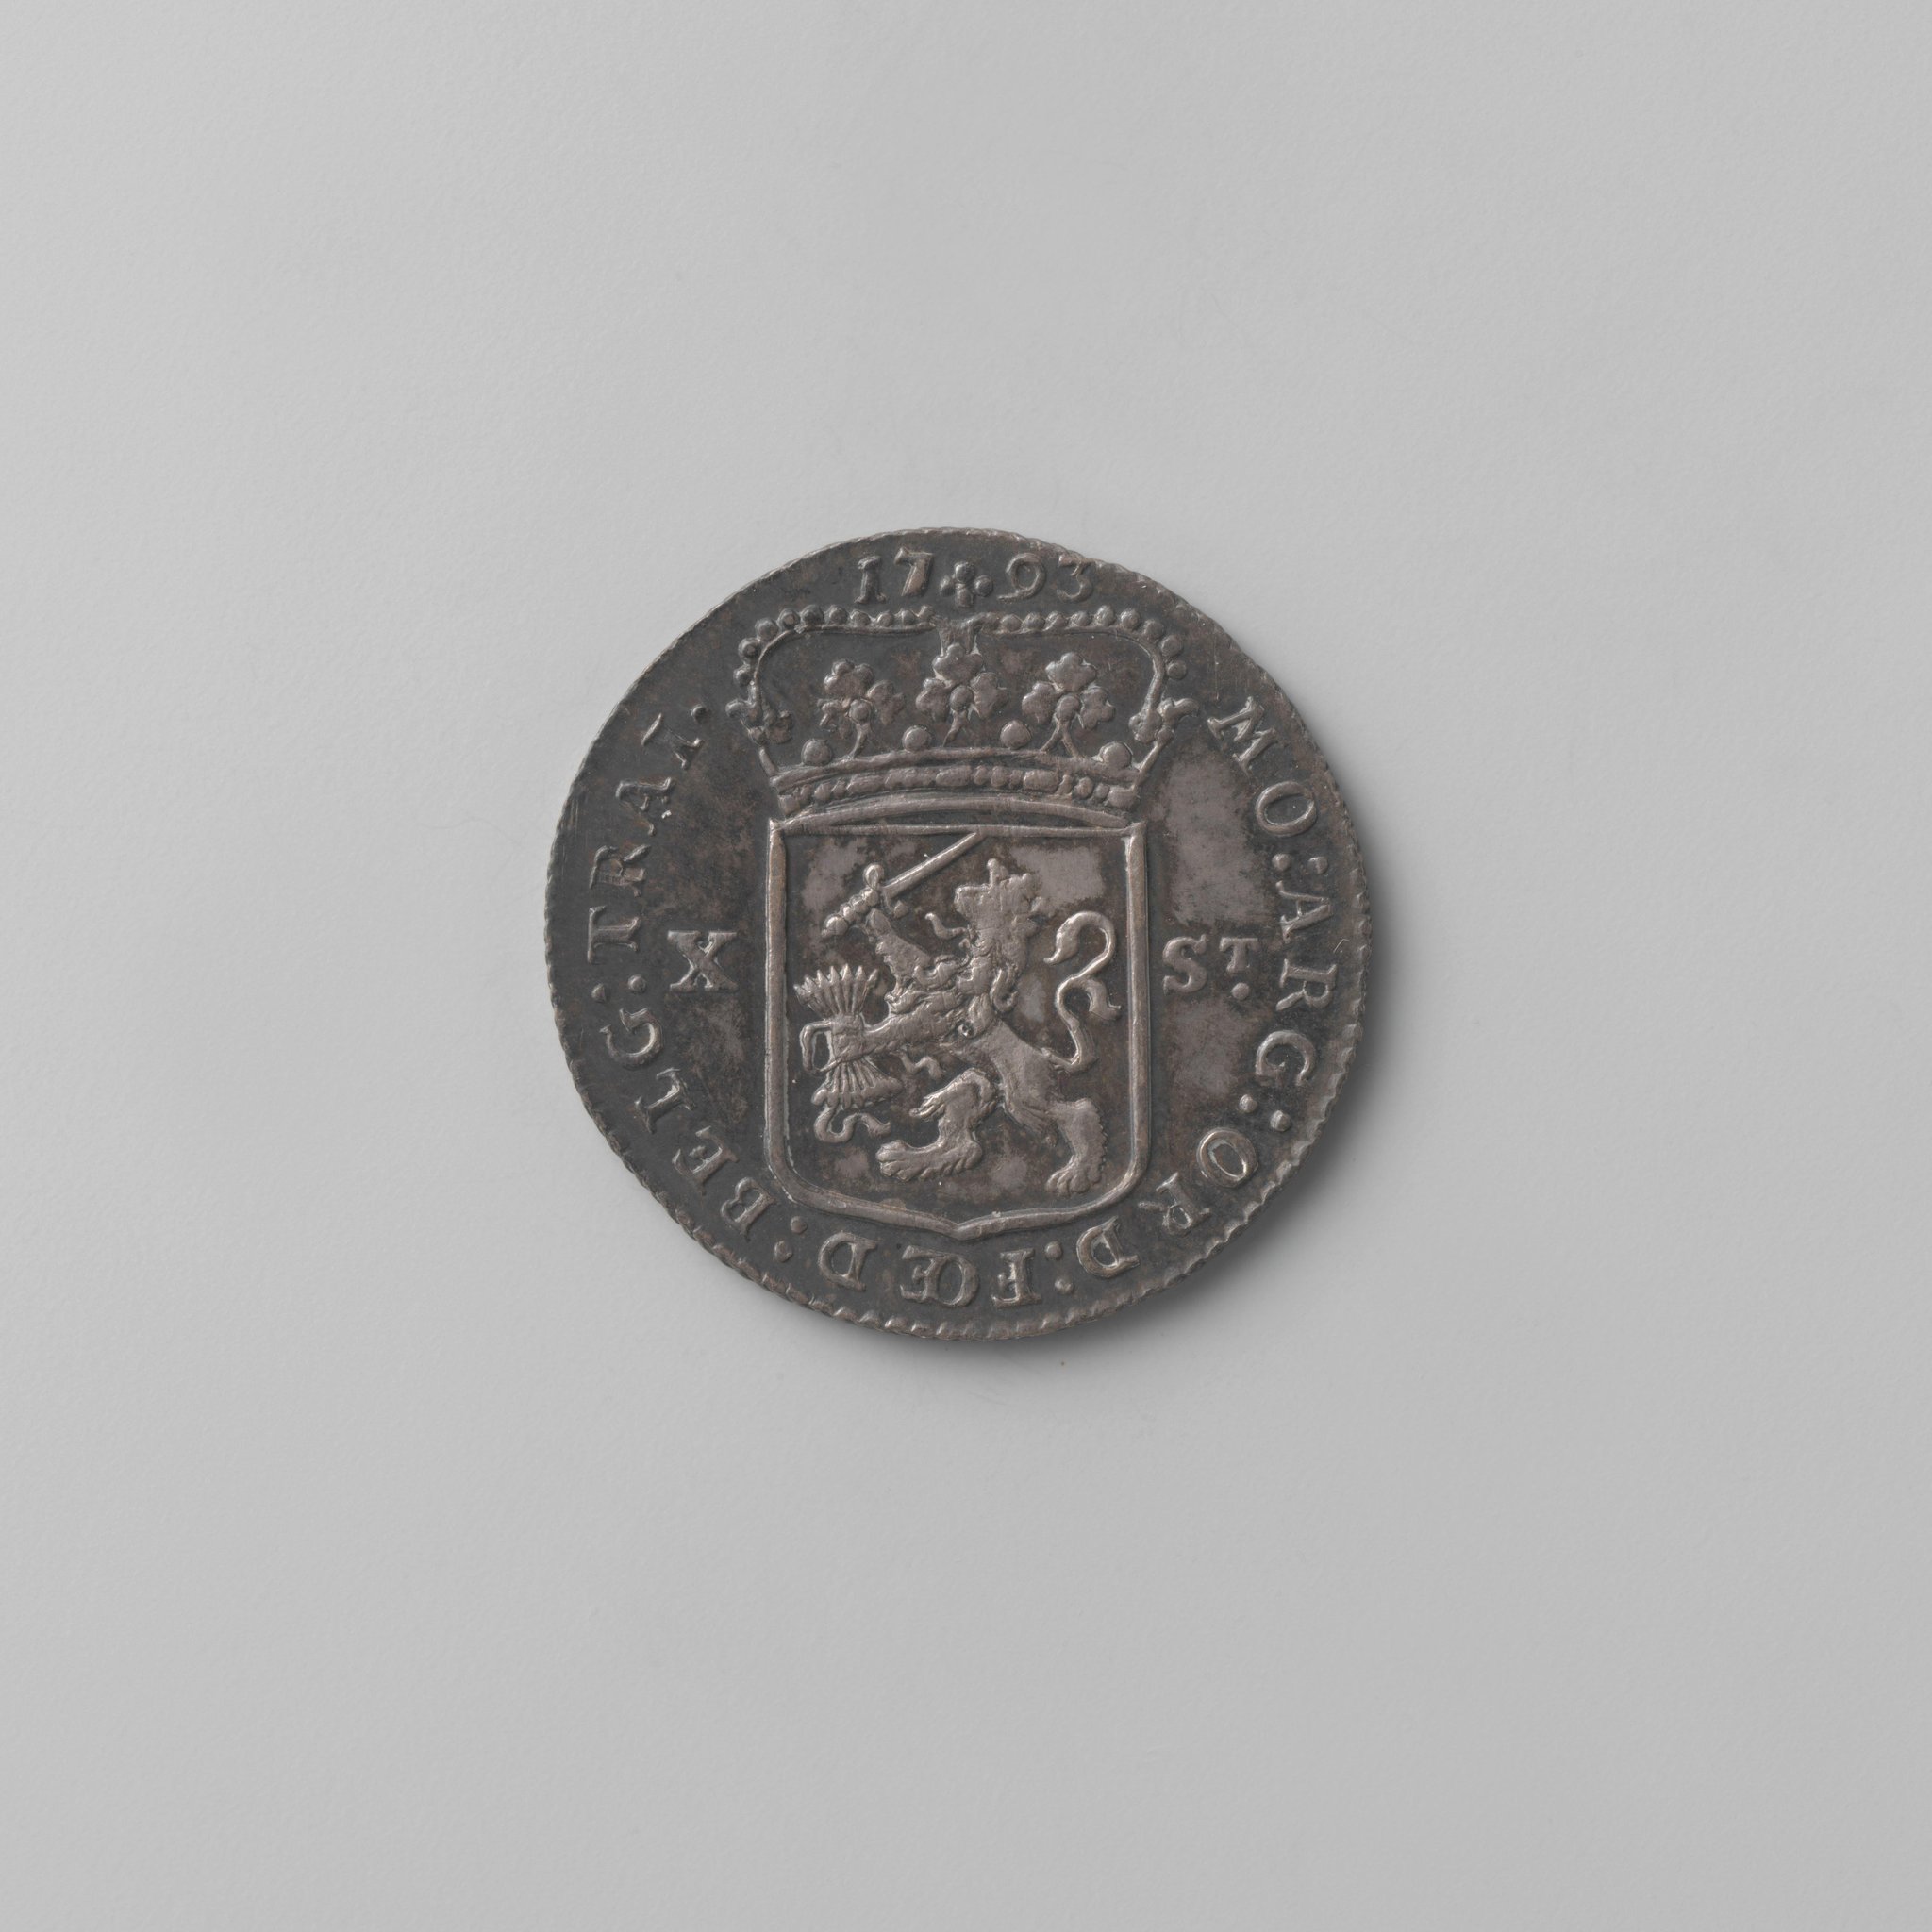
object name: coin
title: Utrecht, halve gulden, 1793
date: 1793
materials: silver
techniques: striking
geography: utrecht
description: Zilveren munt. Voorzijde: tussen waarde-aanduiding X St gekroond generaliteitswapenschild. Jaartal boven kroon. Keerzijde: Nederlandse maagd met vrijheidshoed en speer, leunend op een bijbel op een altaar. Kabelrand.